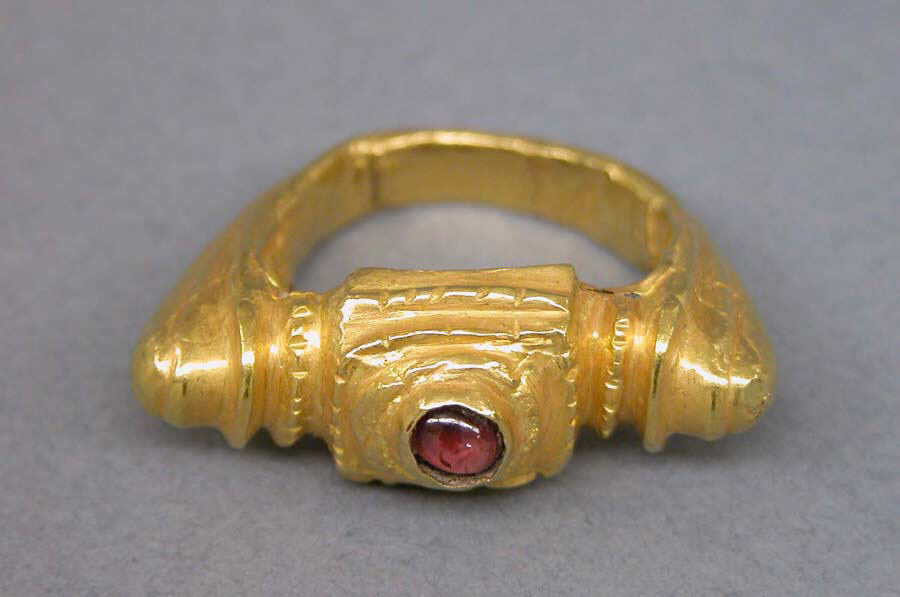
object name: ring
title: Ring with Reddish-purple Stone Set in Square Bezel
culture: indonesian, javanese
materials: gold, stone